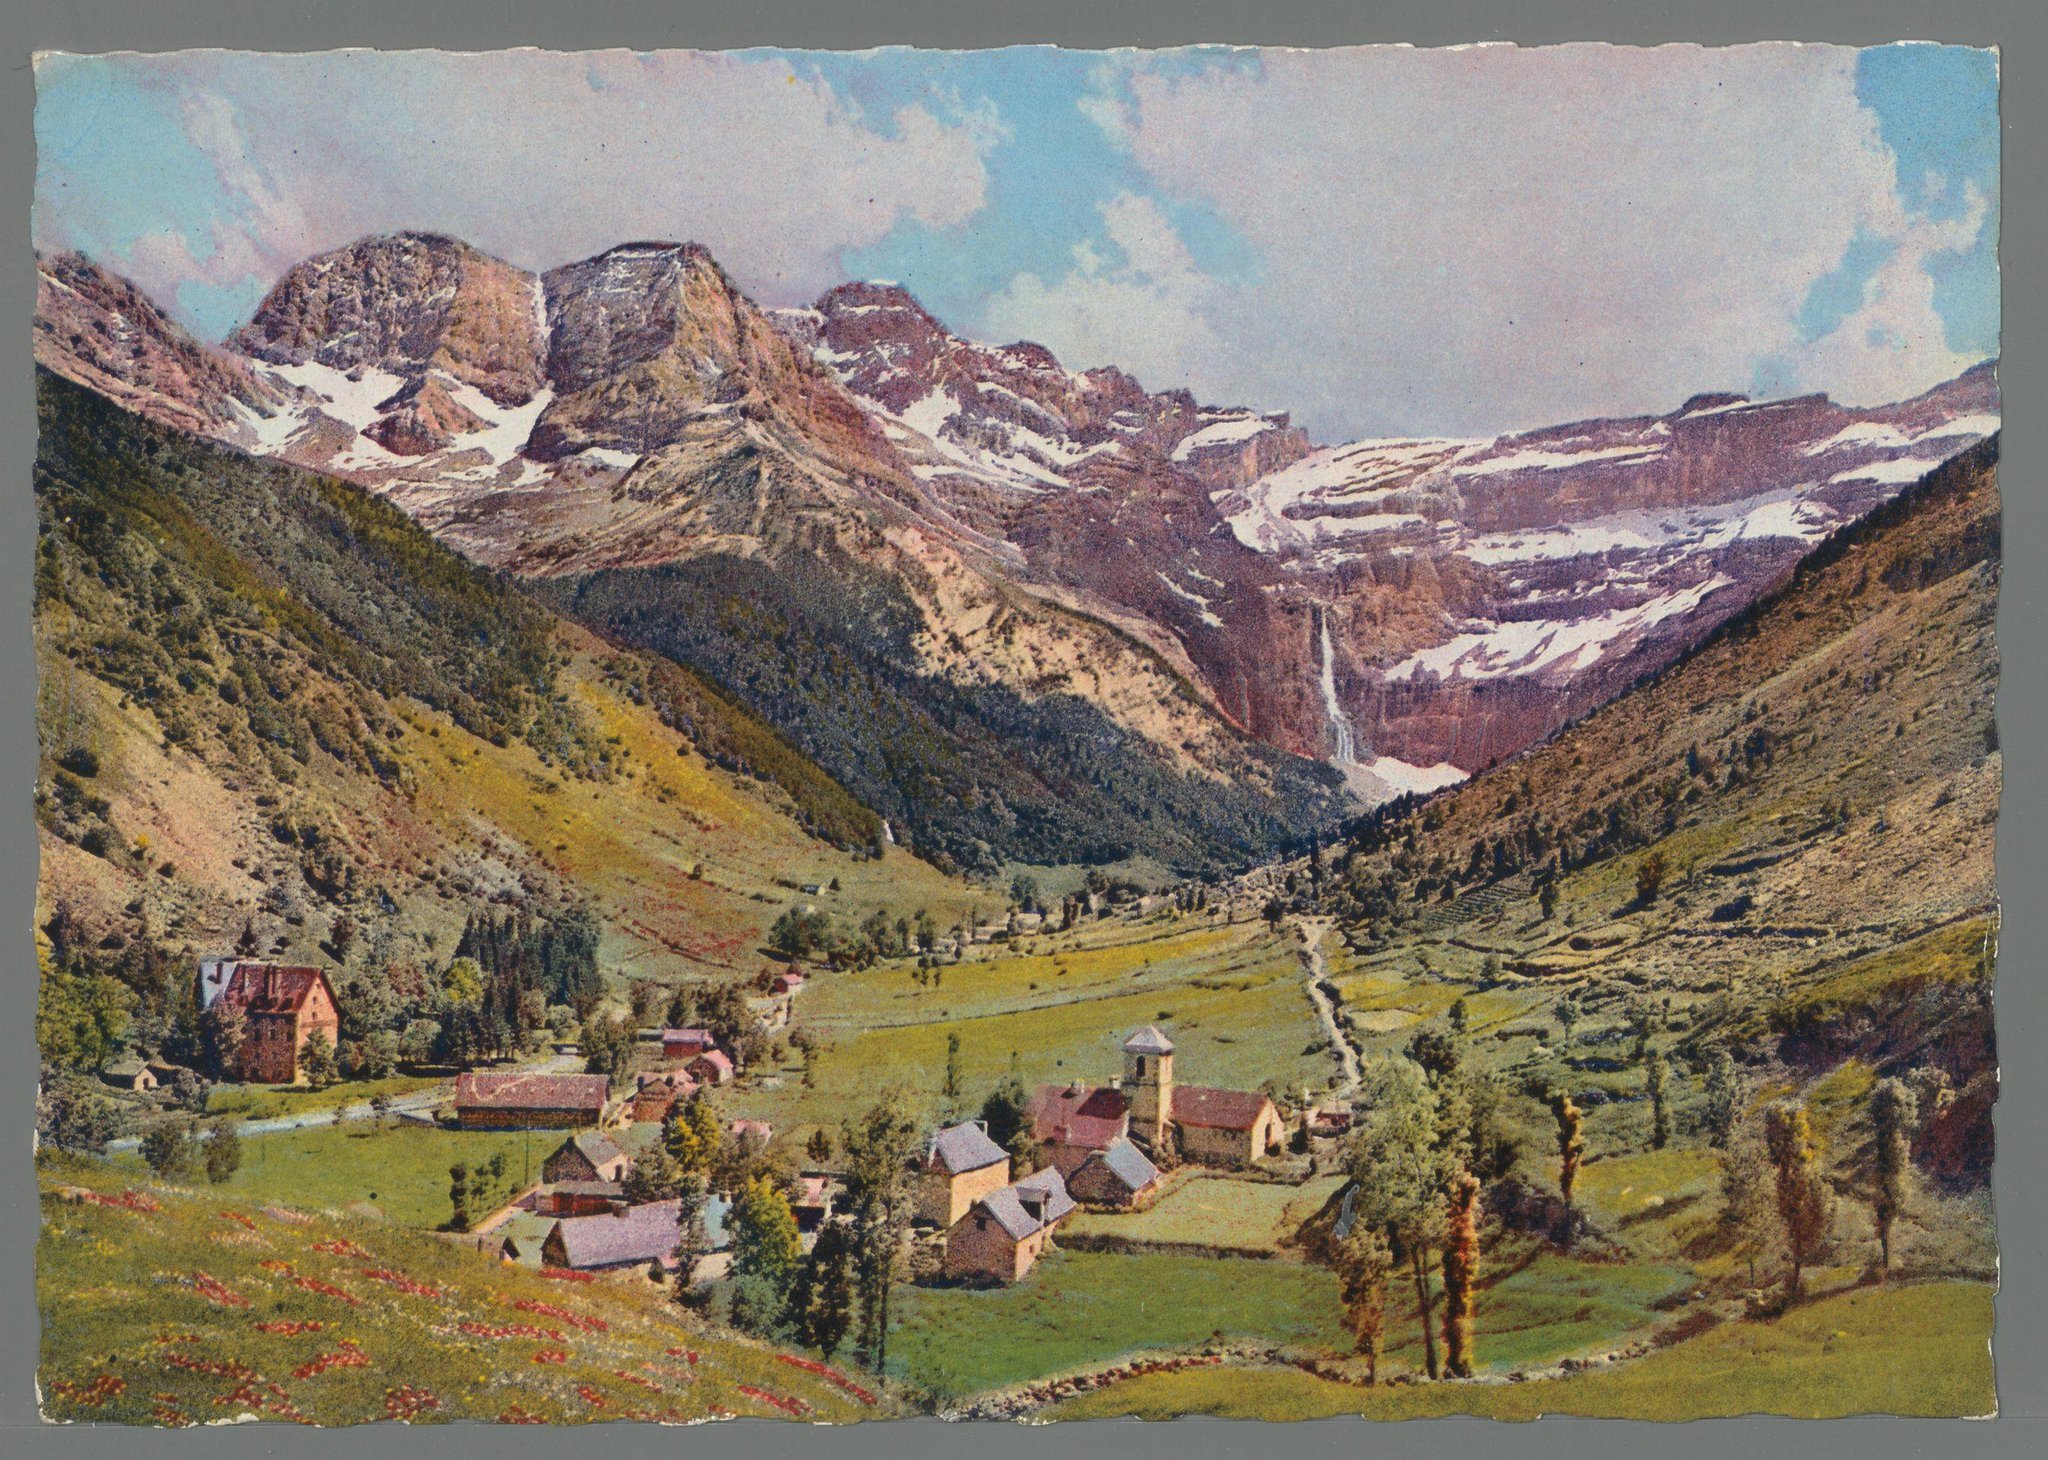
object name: photomechanical print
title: Gavarnie. Le Cirque et le Village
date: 1958-1990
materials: cardboard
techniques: offset printed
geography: nice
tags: prospect of village, silhouette of village, dale, valley, mountains, gavarnie